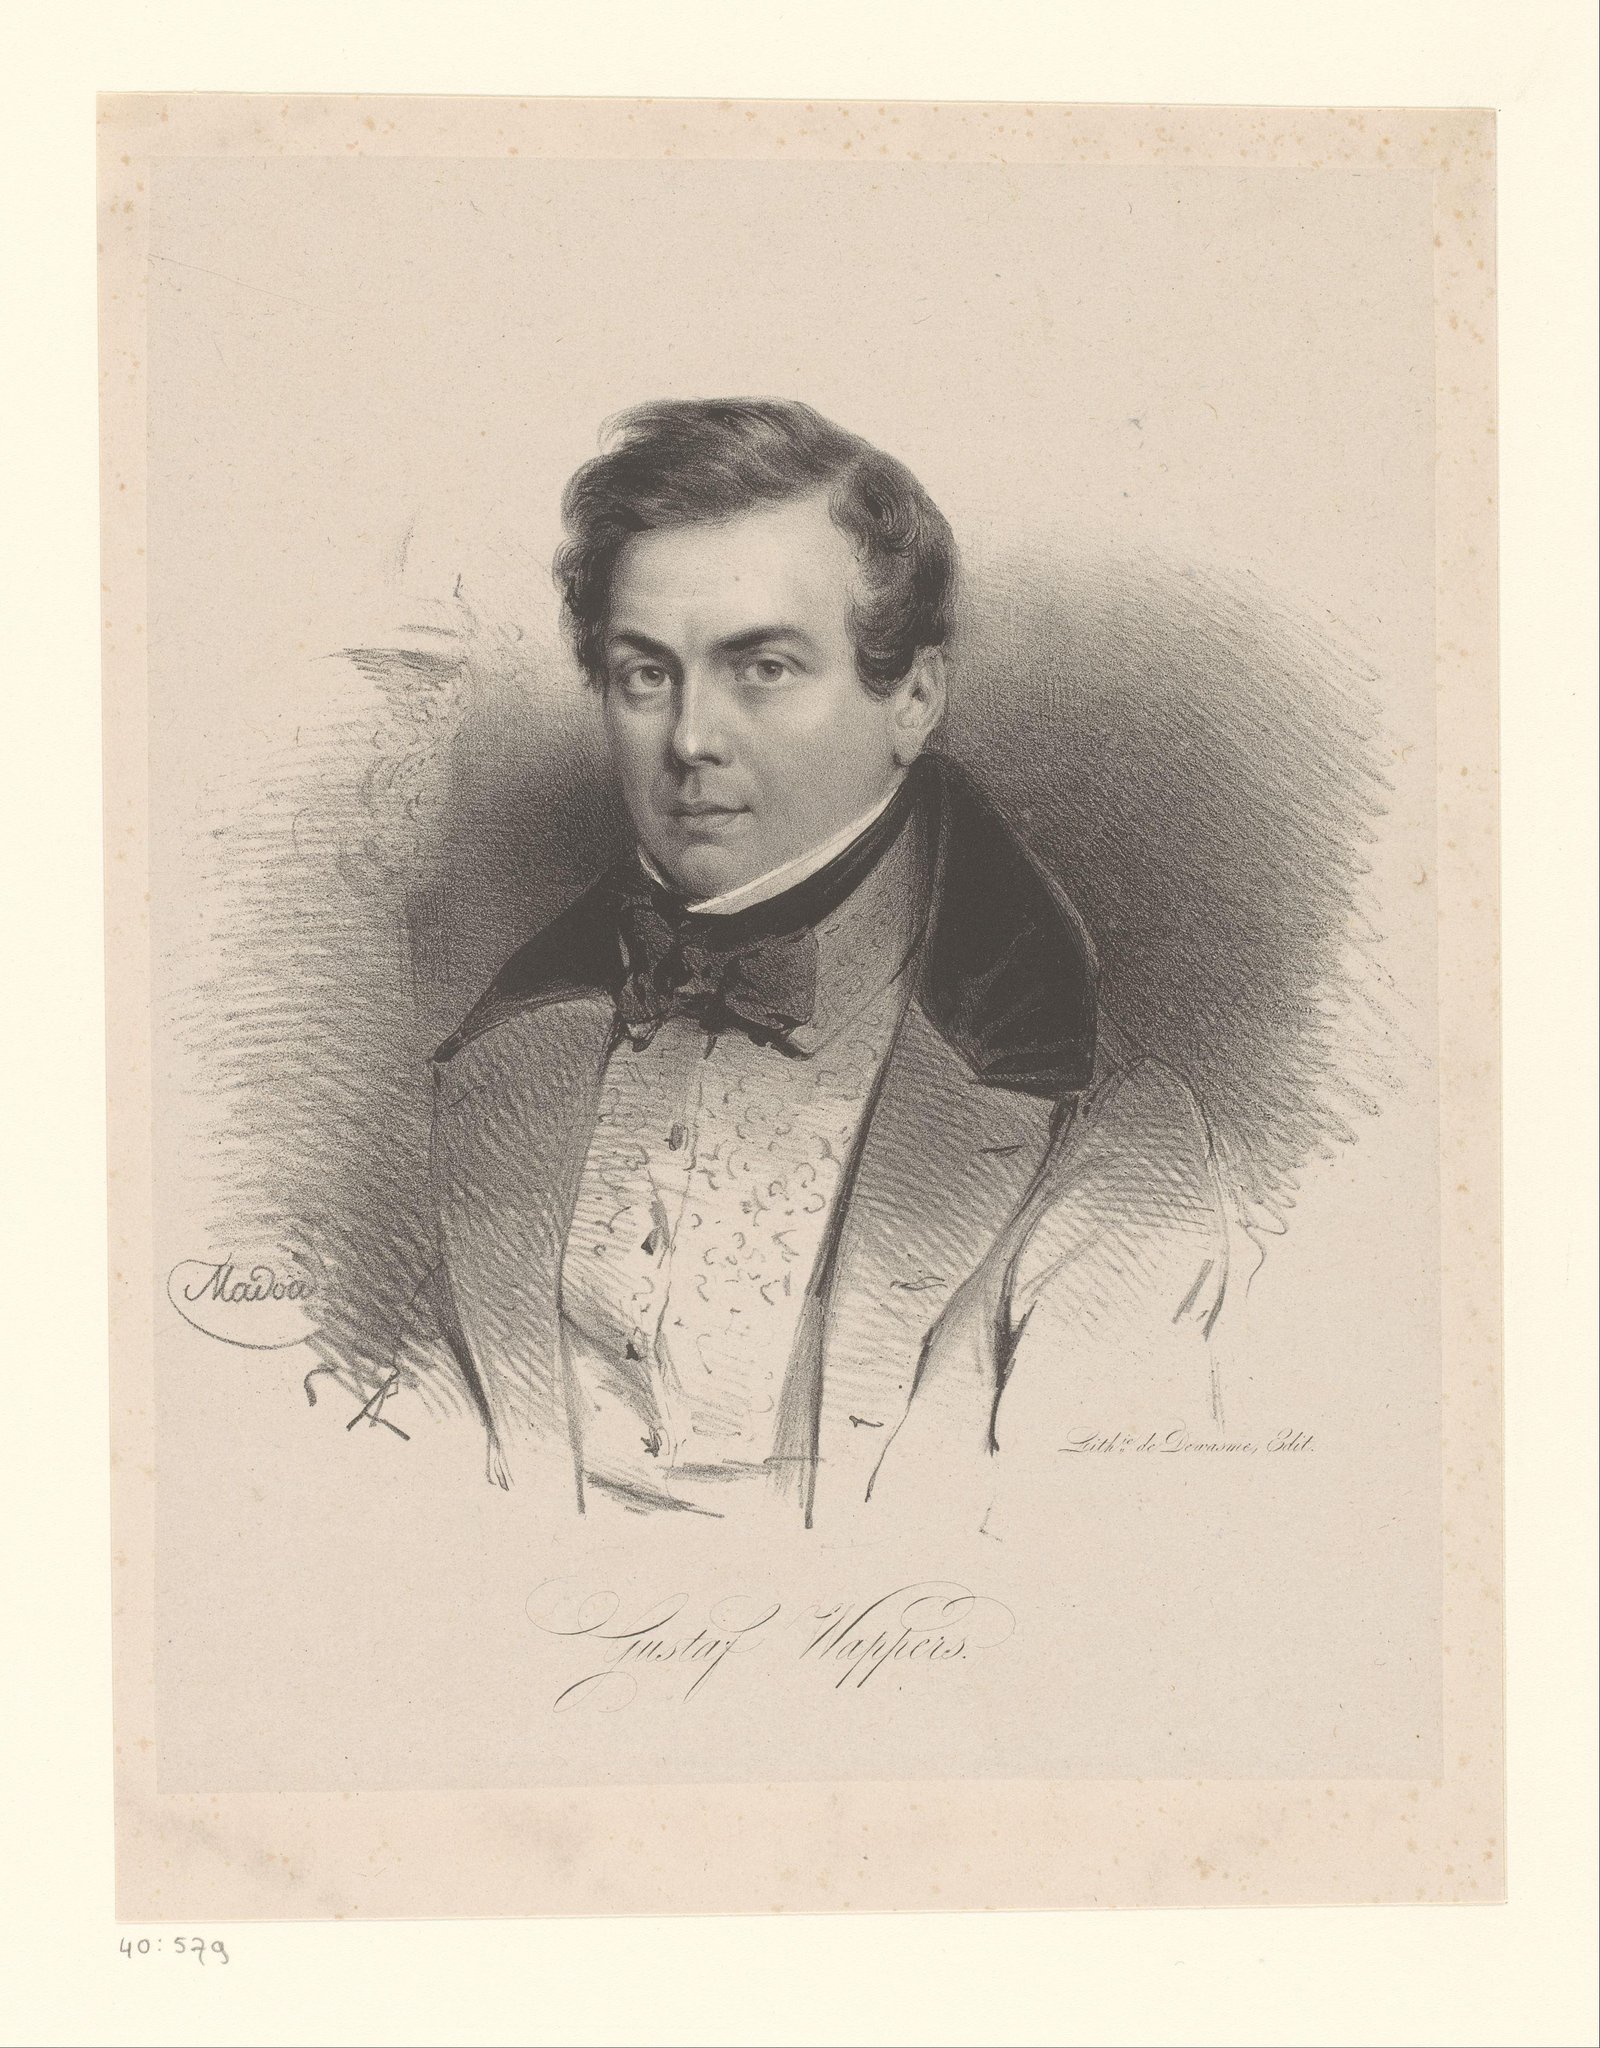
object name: print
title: Gustaf Wappers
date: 1825-1827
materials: paper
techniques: lithograph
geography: brussels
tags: antwerp, paris, painter, print maker, draughtsman, gustave wappers, adult man, historical persons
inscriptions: collector's mark: Lugt 2760, collector's mark: Lugt 2228